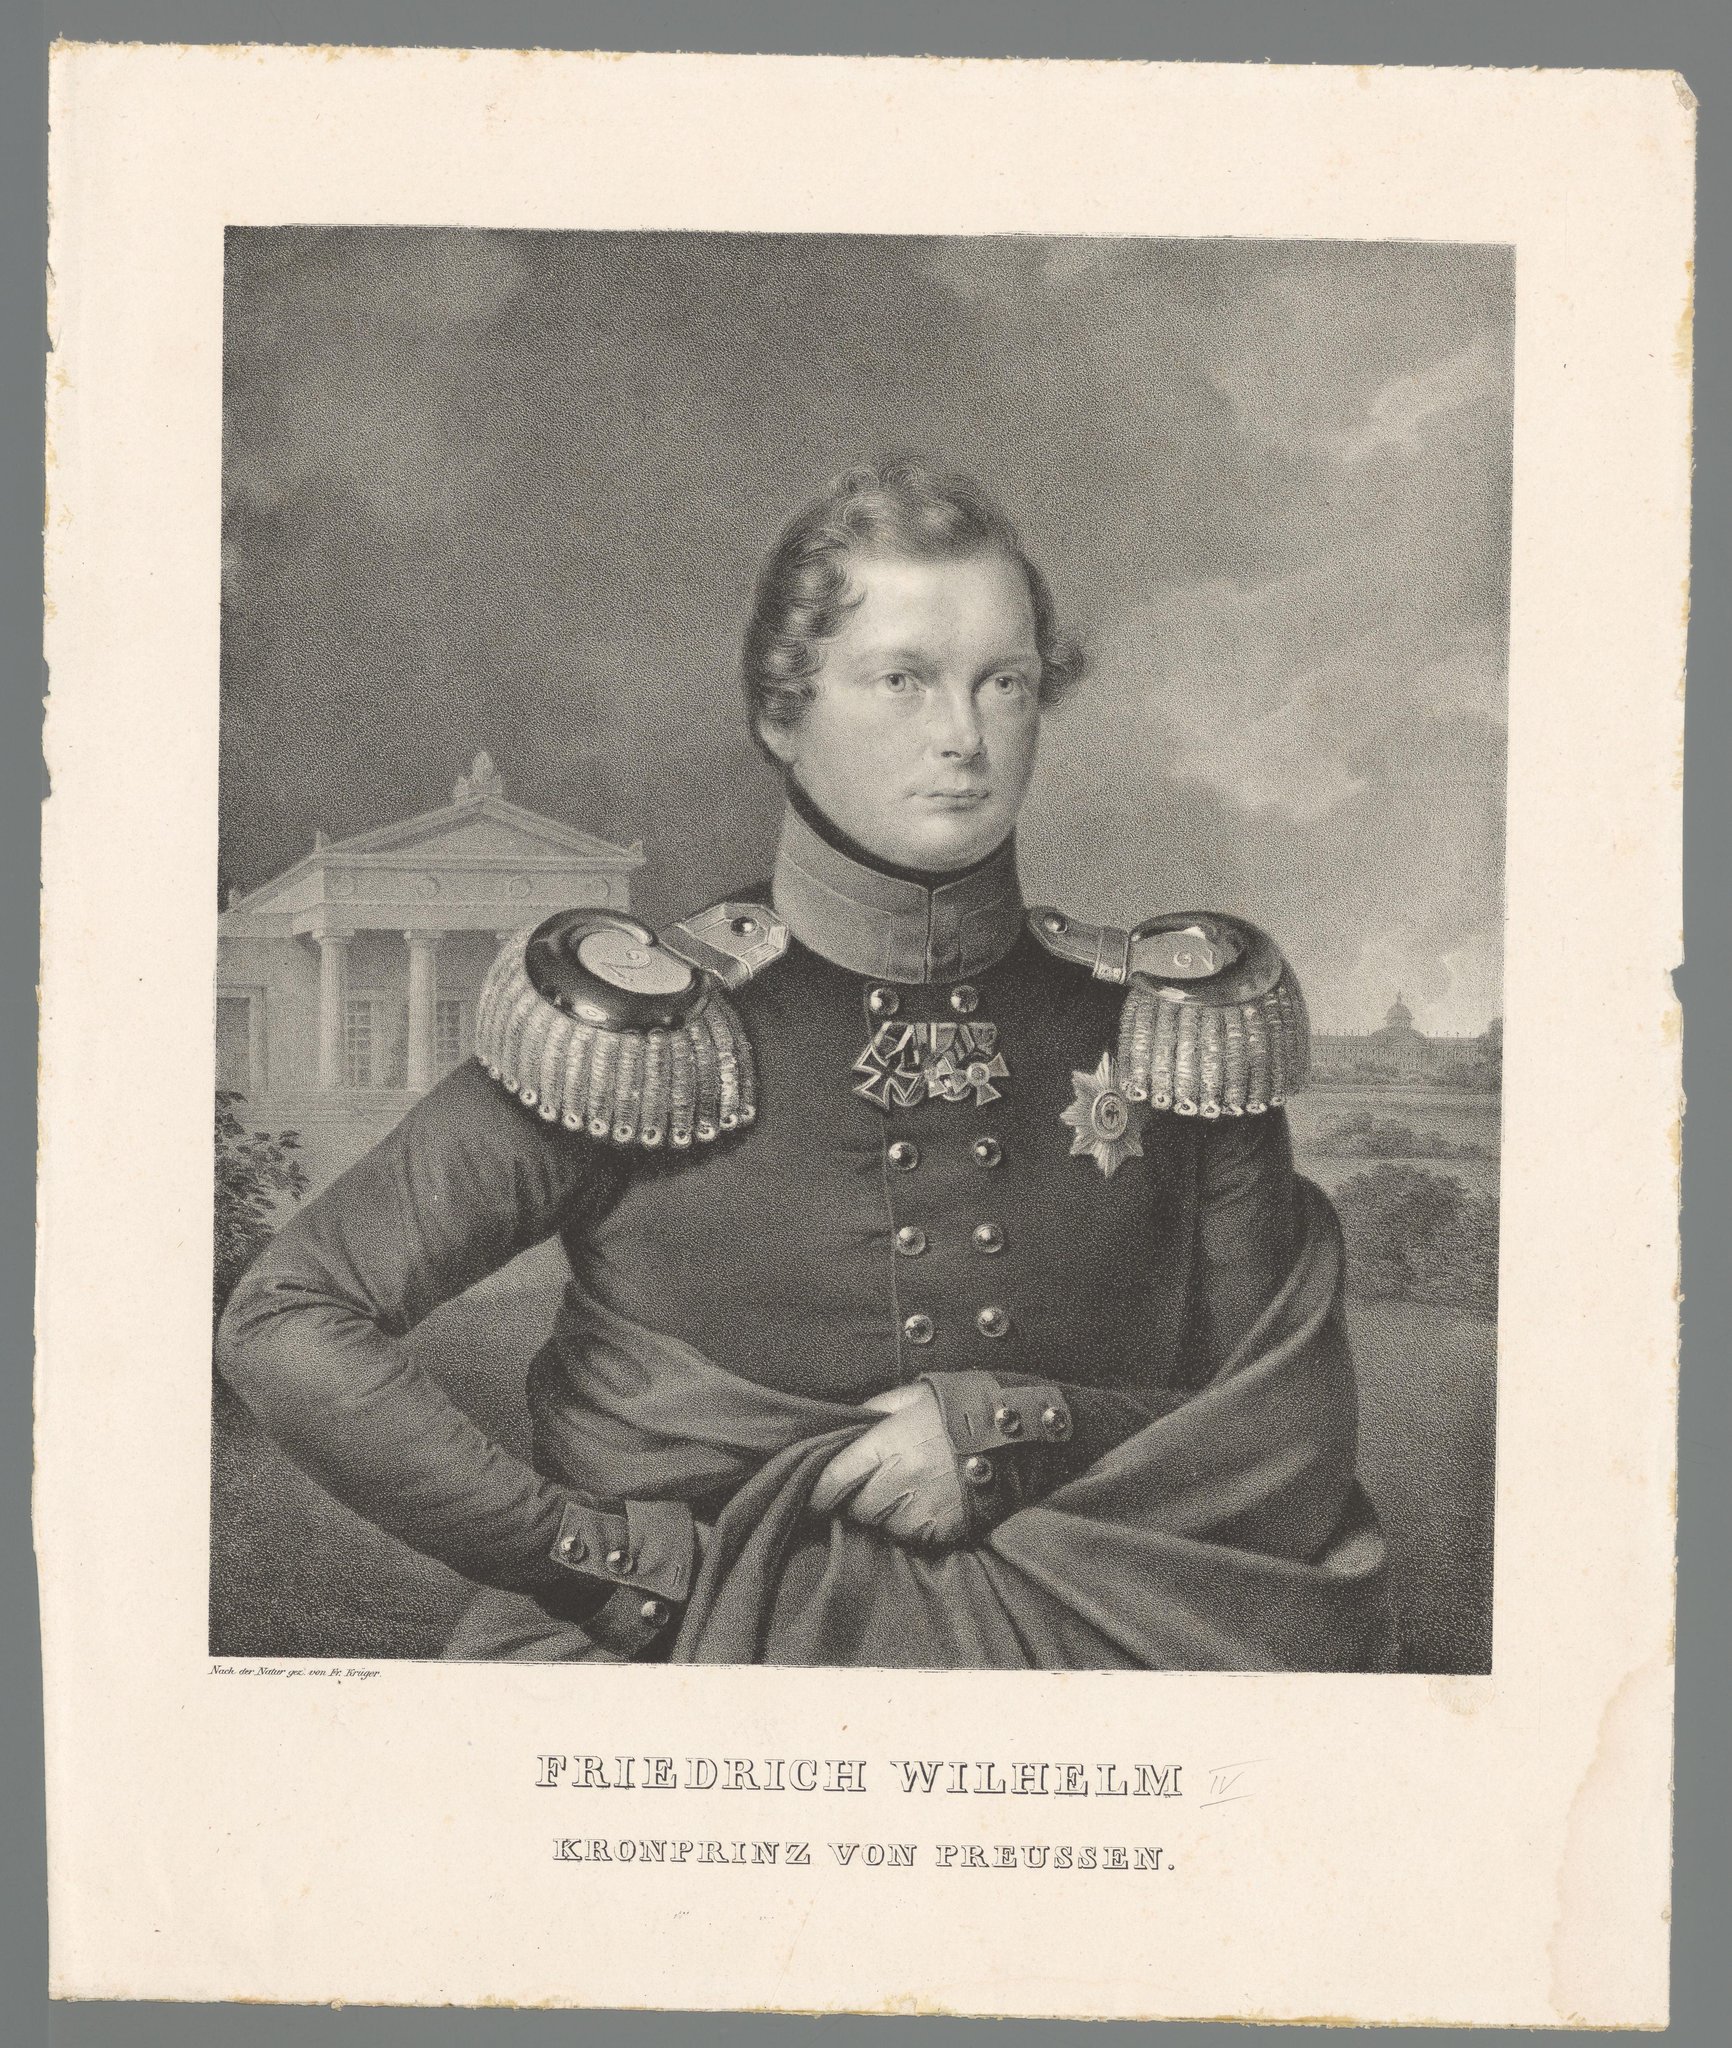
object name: print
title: Friedrich Wilhelm, Kronprinz von Preussen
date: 1820-1870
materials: paper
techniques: lithograph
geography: berlin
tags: berlin, frederik willem iv (koning van pruisen), adult man, historical persons, civic architecture; edifices; dwellings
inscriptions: collector's mark: Lugt 2228, check stamp: Lugt 4519